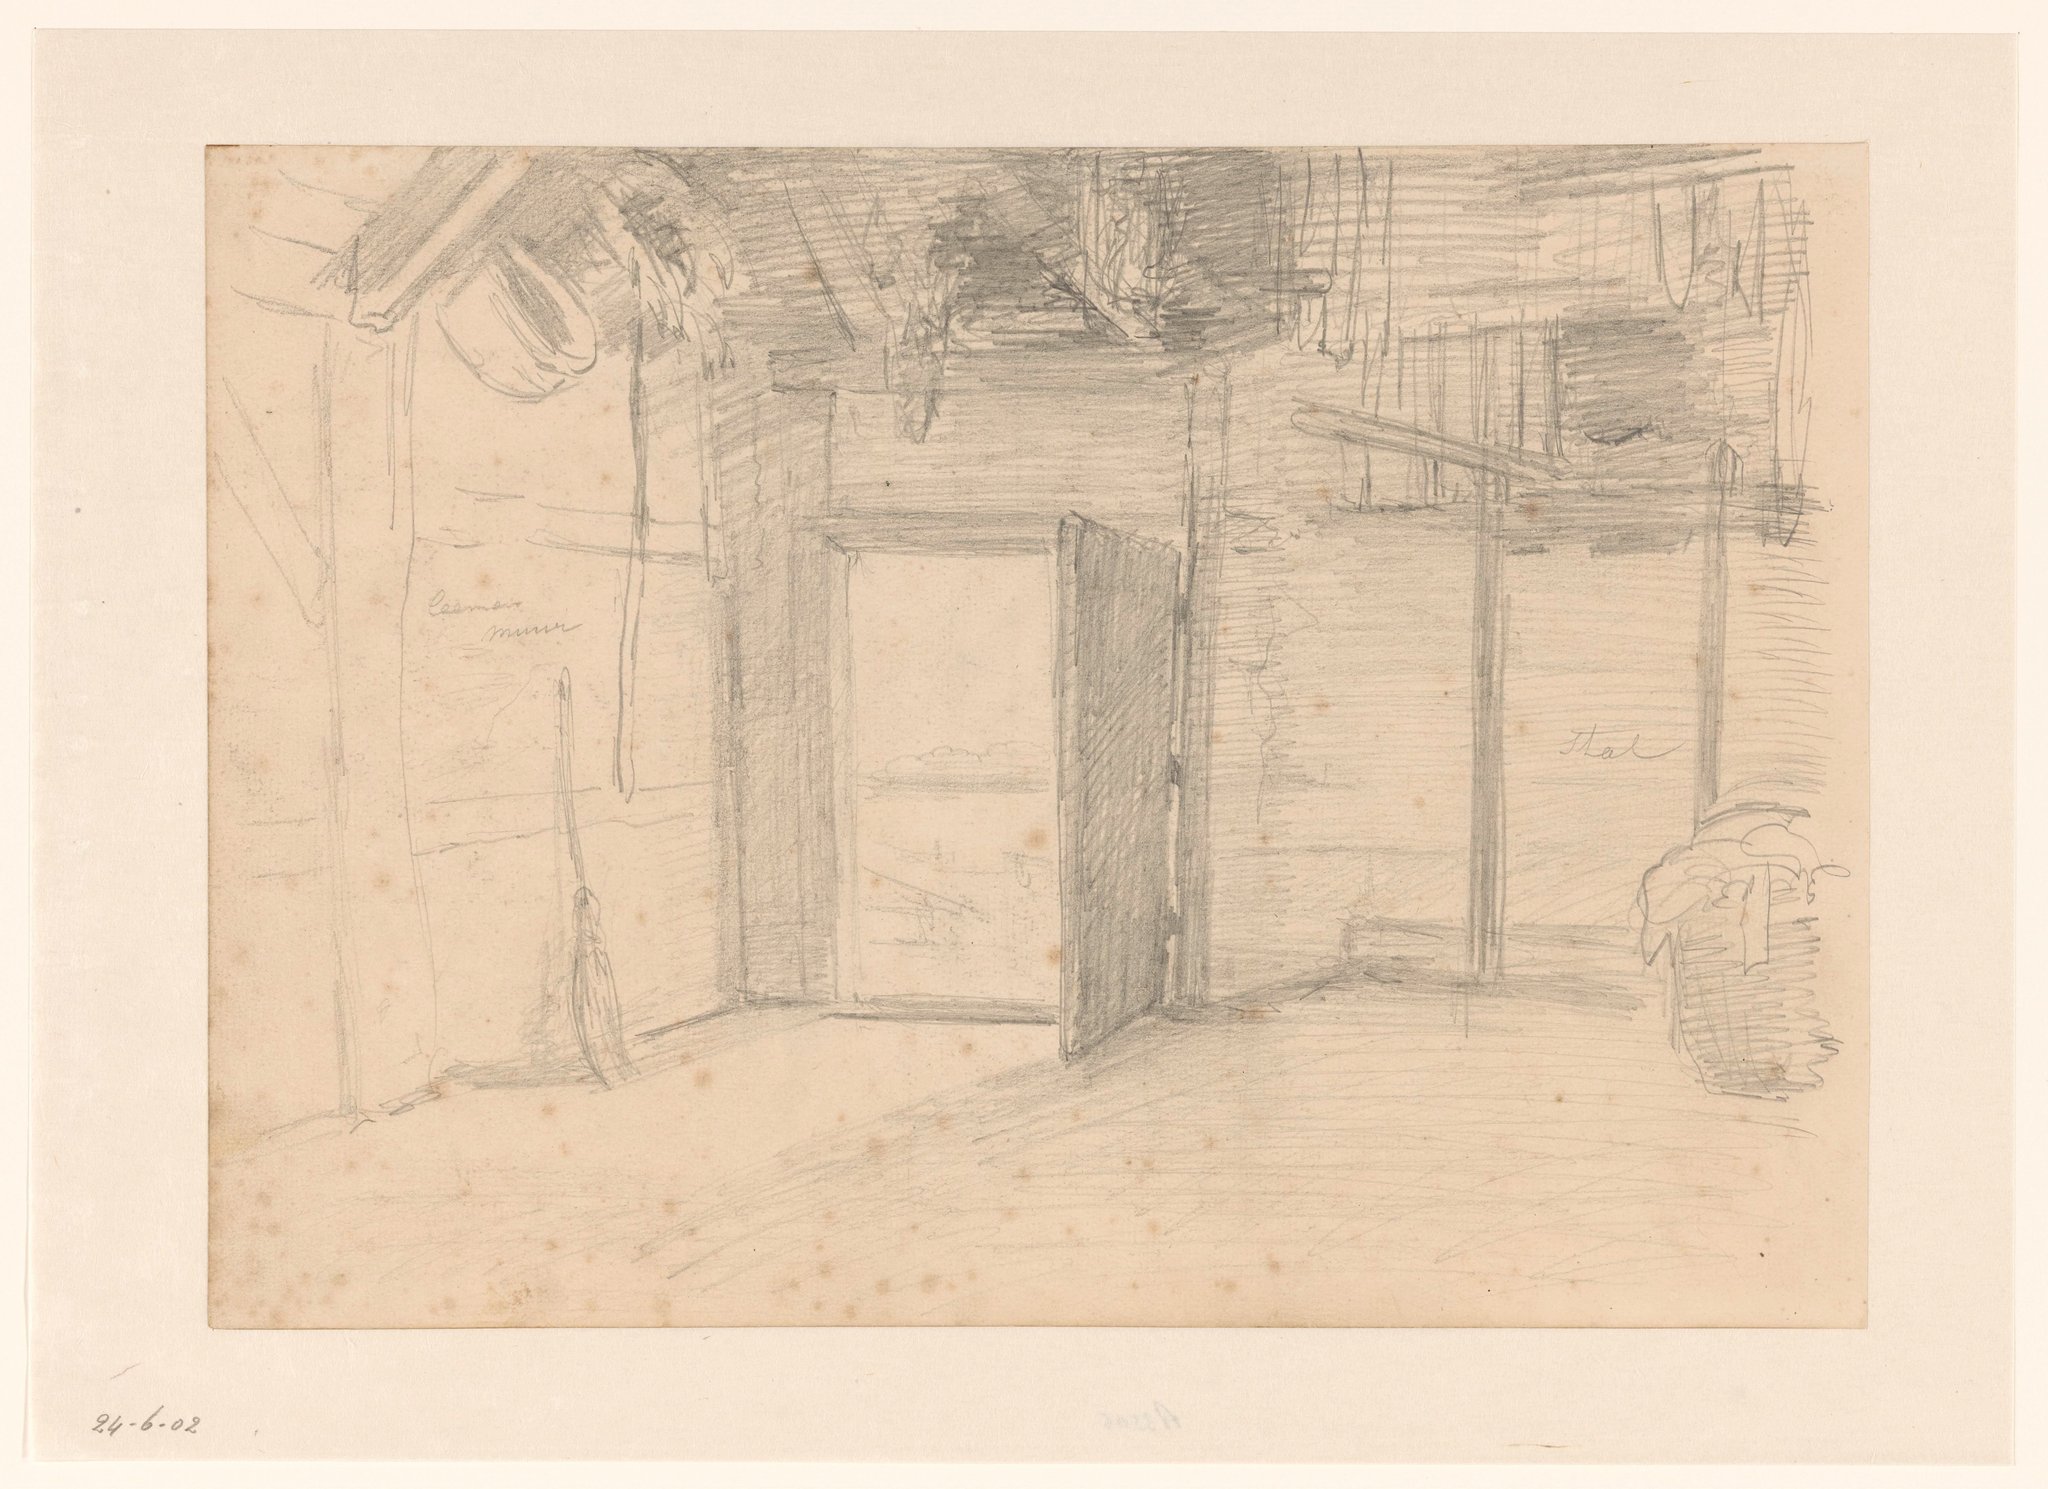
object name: drawing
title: Vrouwen en kinderen en een kind in een kinderstoel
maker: hendrik valkenburg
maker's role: draughtsman, painter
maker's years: 1826-1896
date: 1836-1896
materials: paper, pencil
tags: family life, interior of the house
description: Interieur met vrouwen en kinderen en een kind in een kinderstoel. Verso: ontwerpen voor optocht-kostuums, met opmerkingen over kleuren.